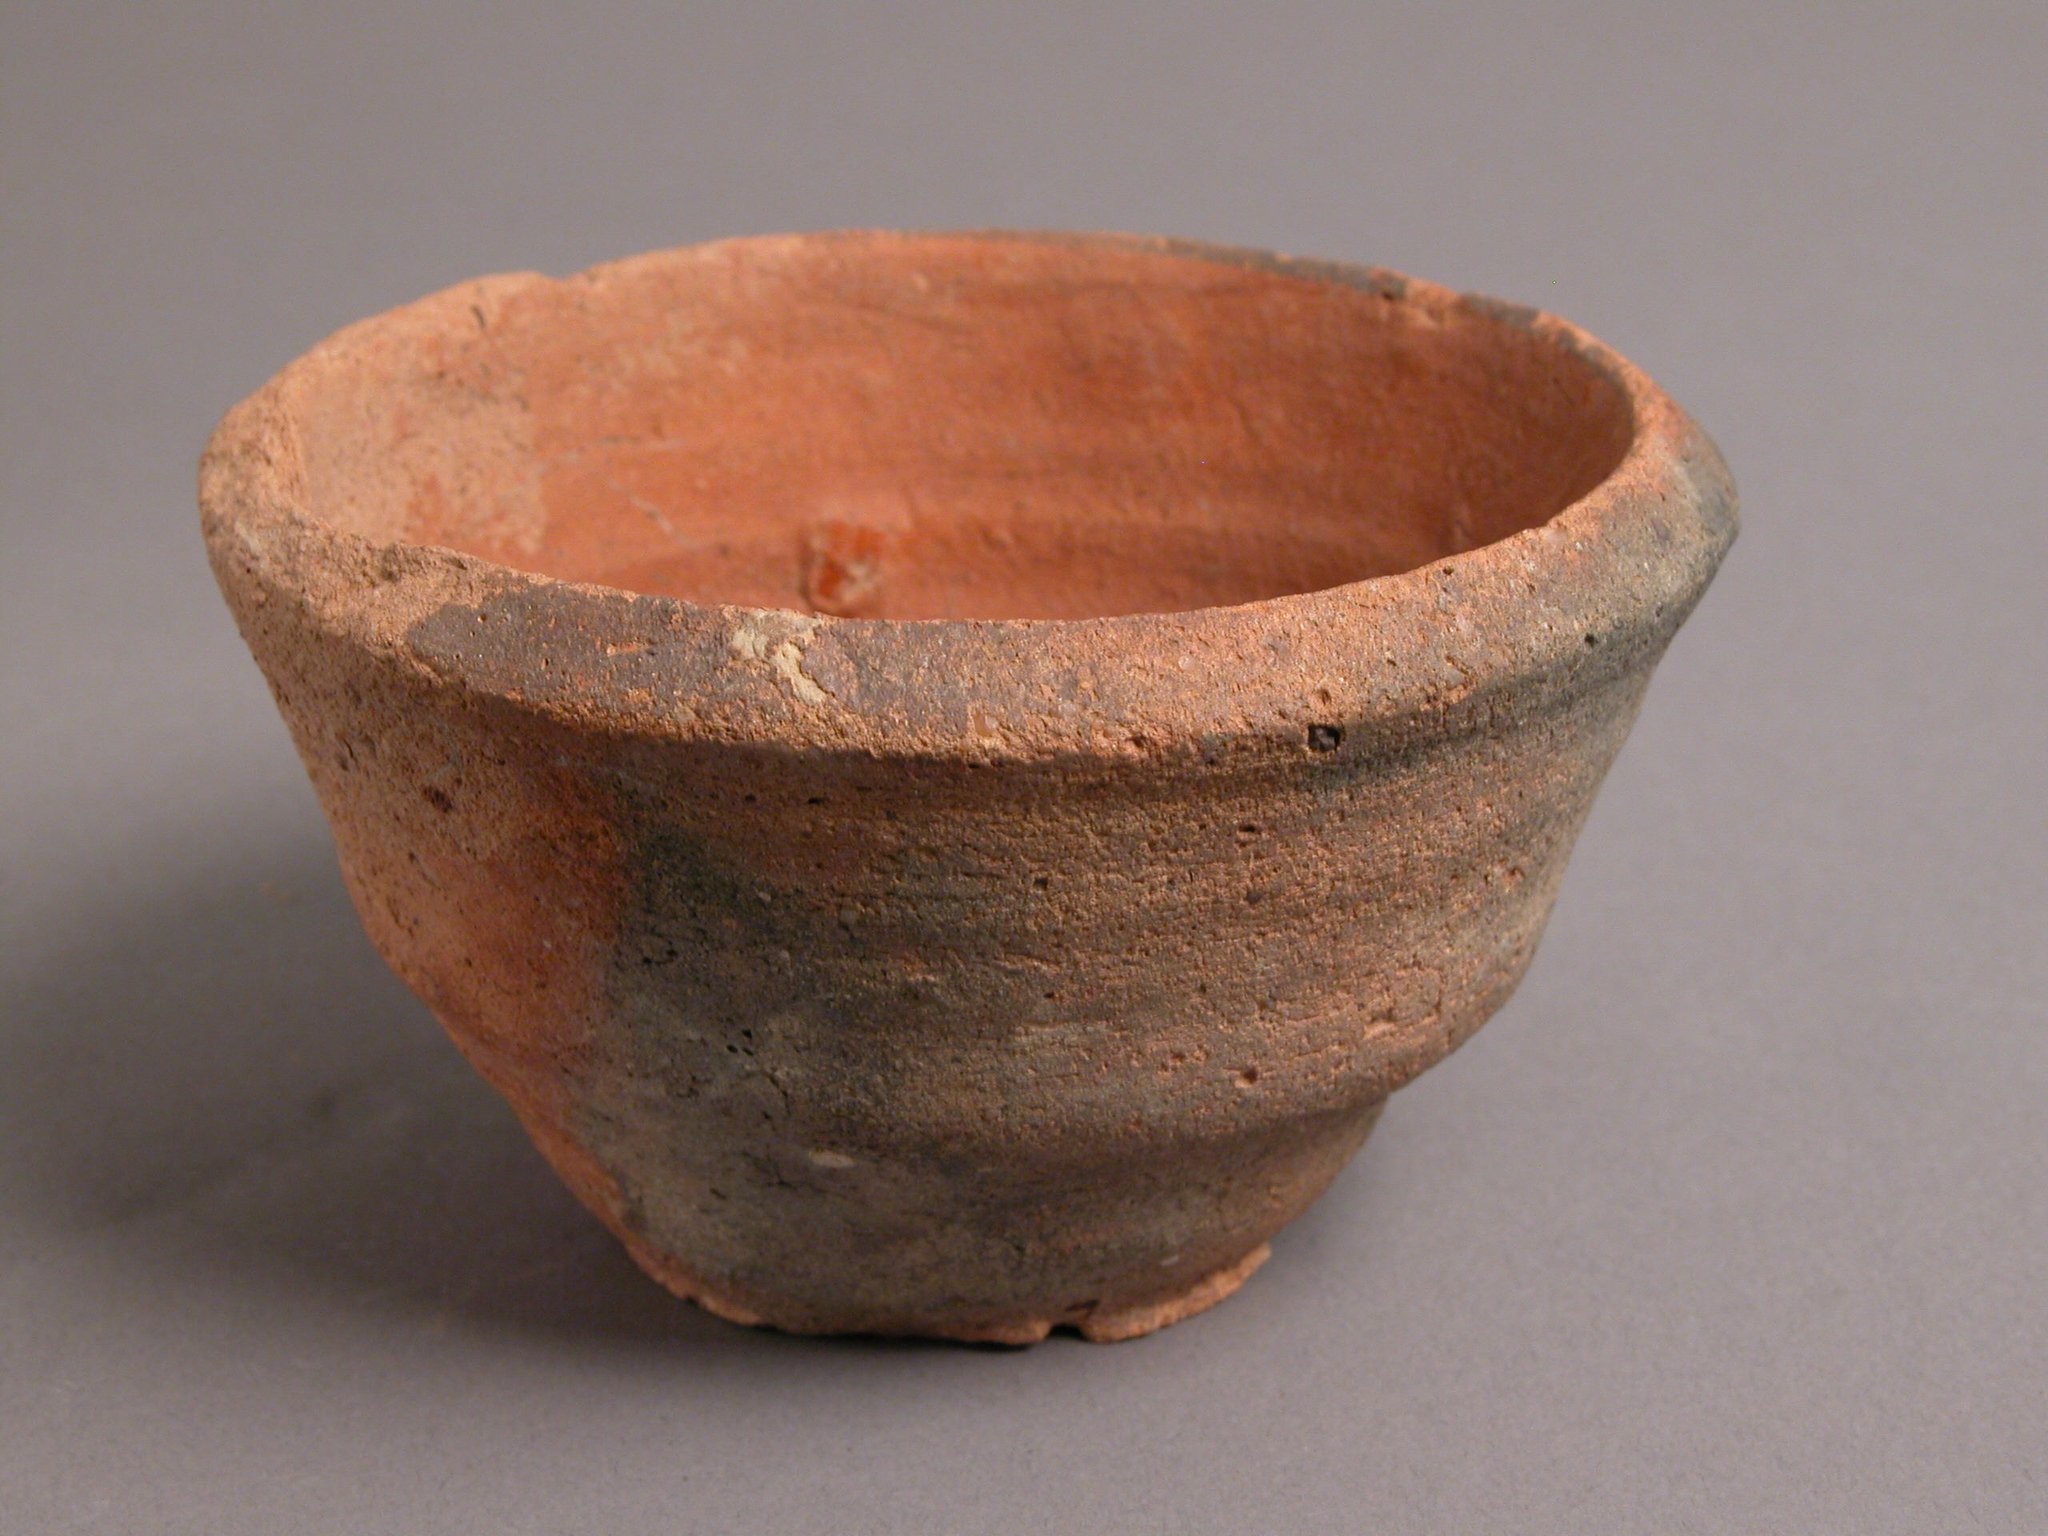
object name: bowl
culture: coptic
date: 301-700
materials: earthenware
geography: egypt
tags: bowls